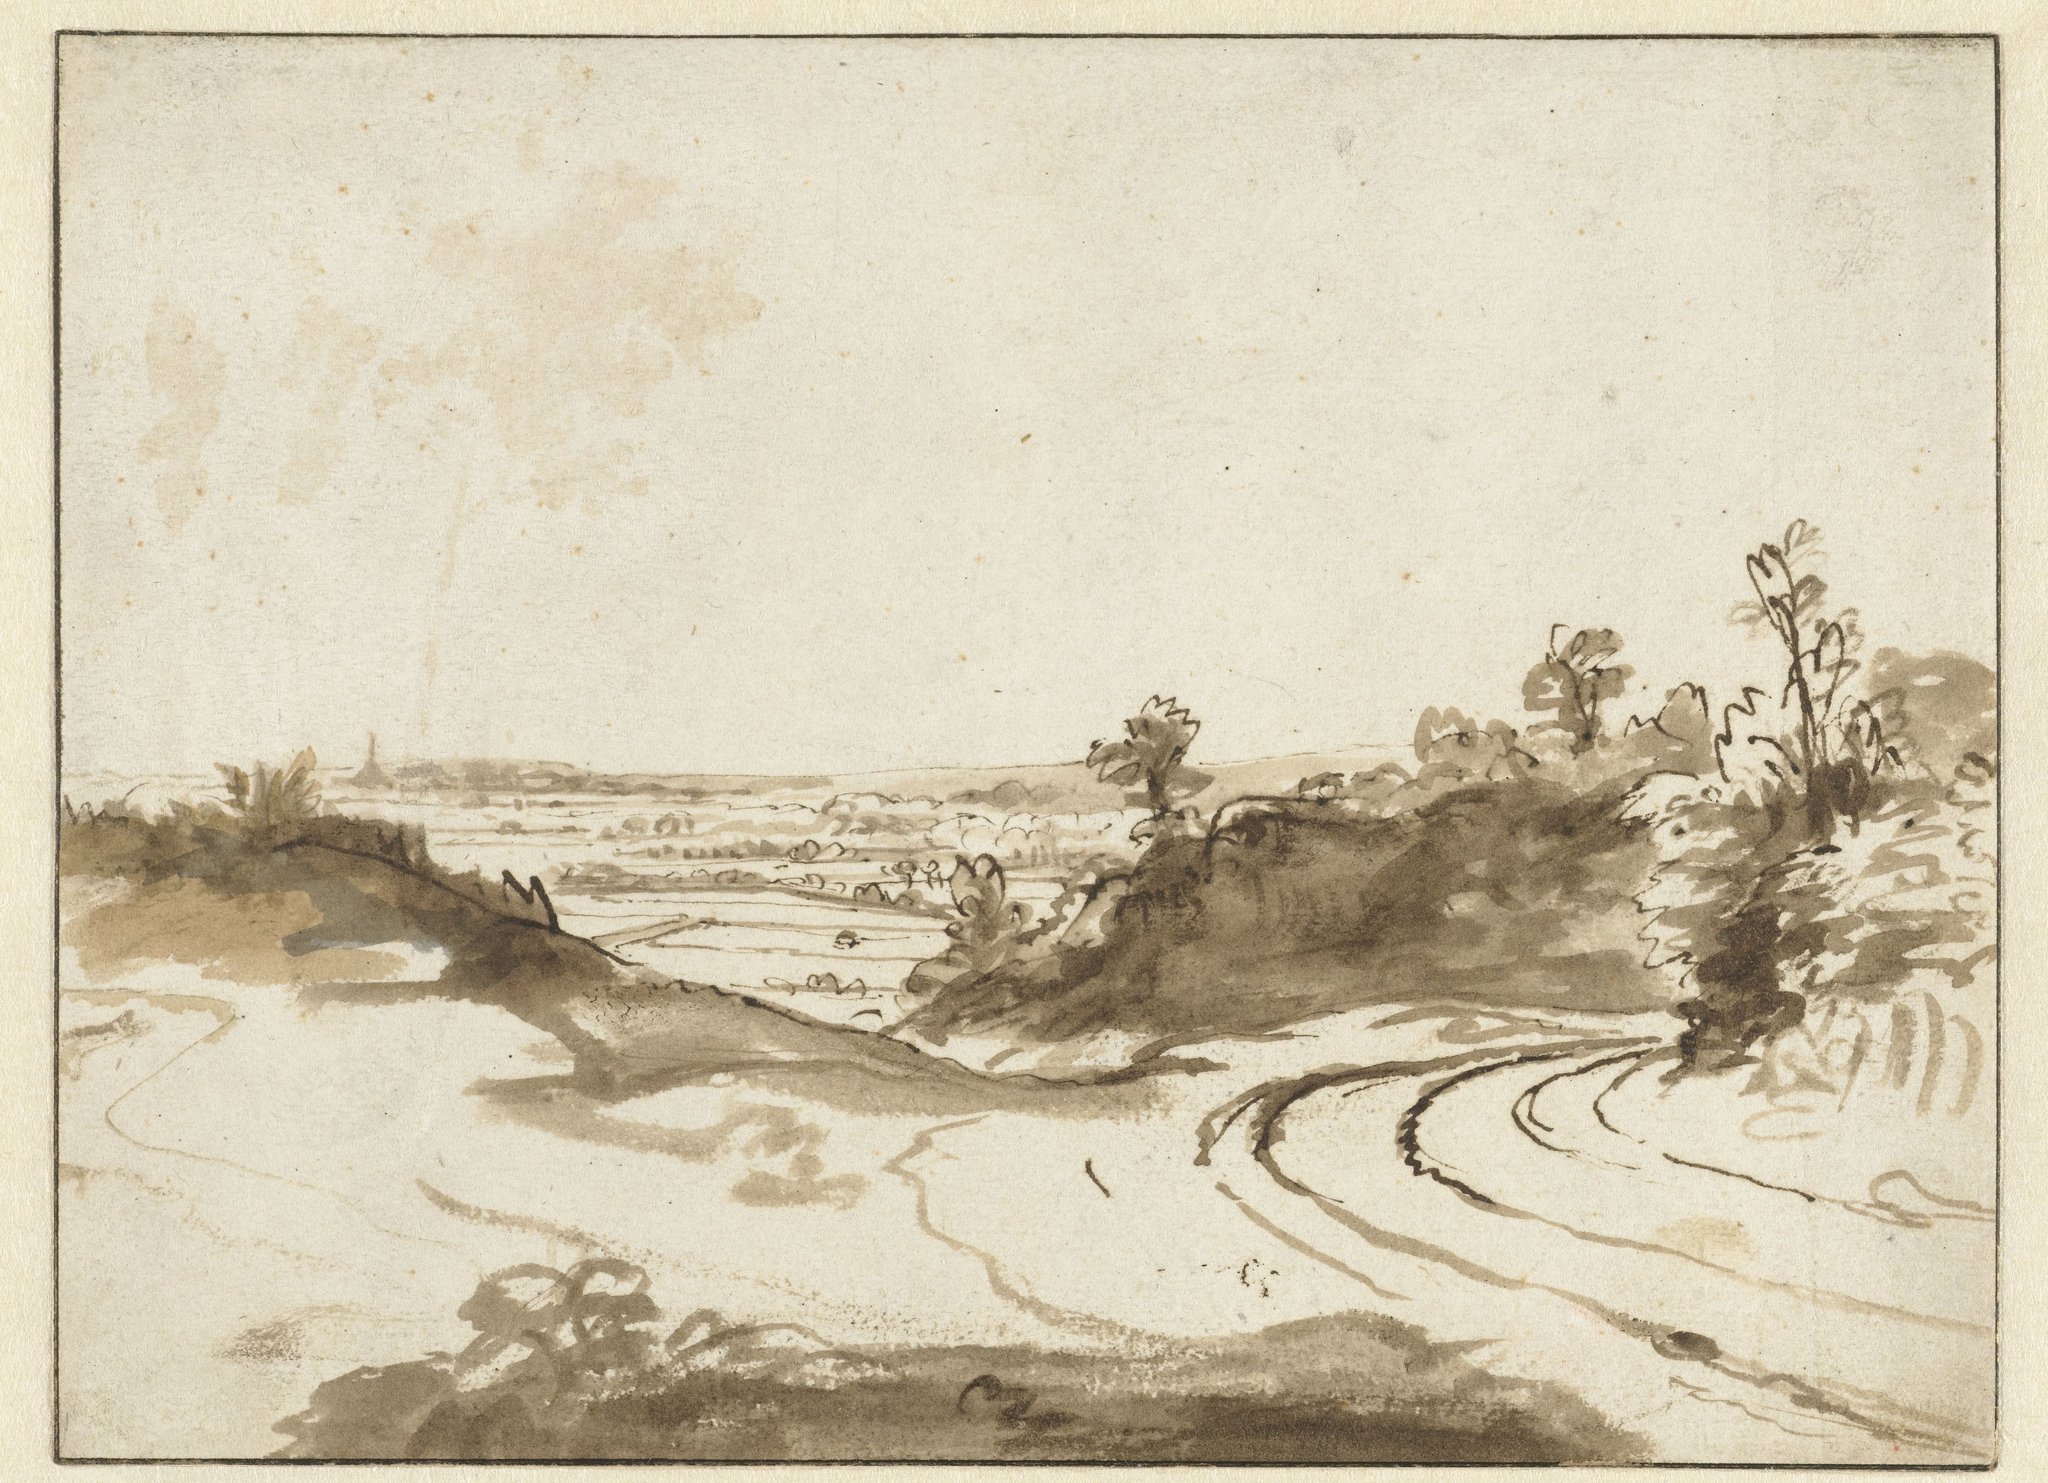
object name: drawing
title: Vergezicht in Gelderland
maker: nicolaes maes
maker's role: draughtsman, painter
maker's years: 1634-1693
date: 1650-1660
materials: ink, paper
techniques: brush, pen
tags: landscapes in the temperate zone, gelderland